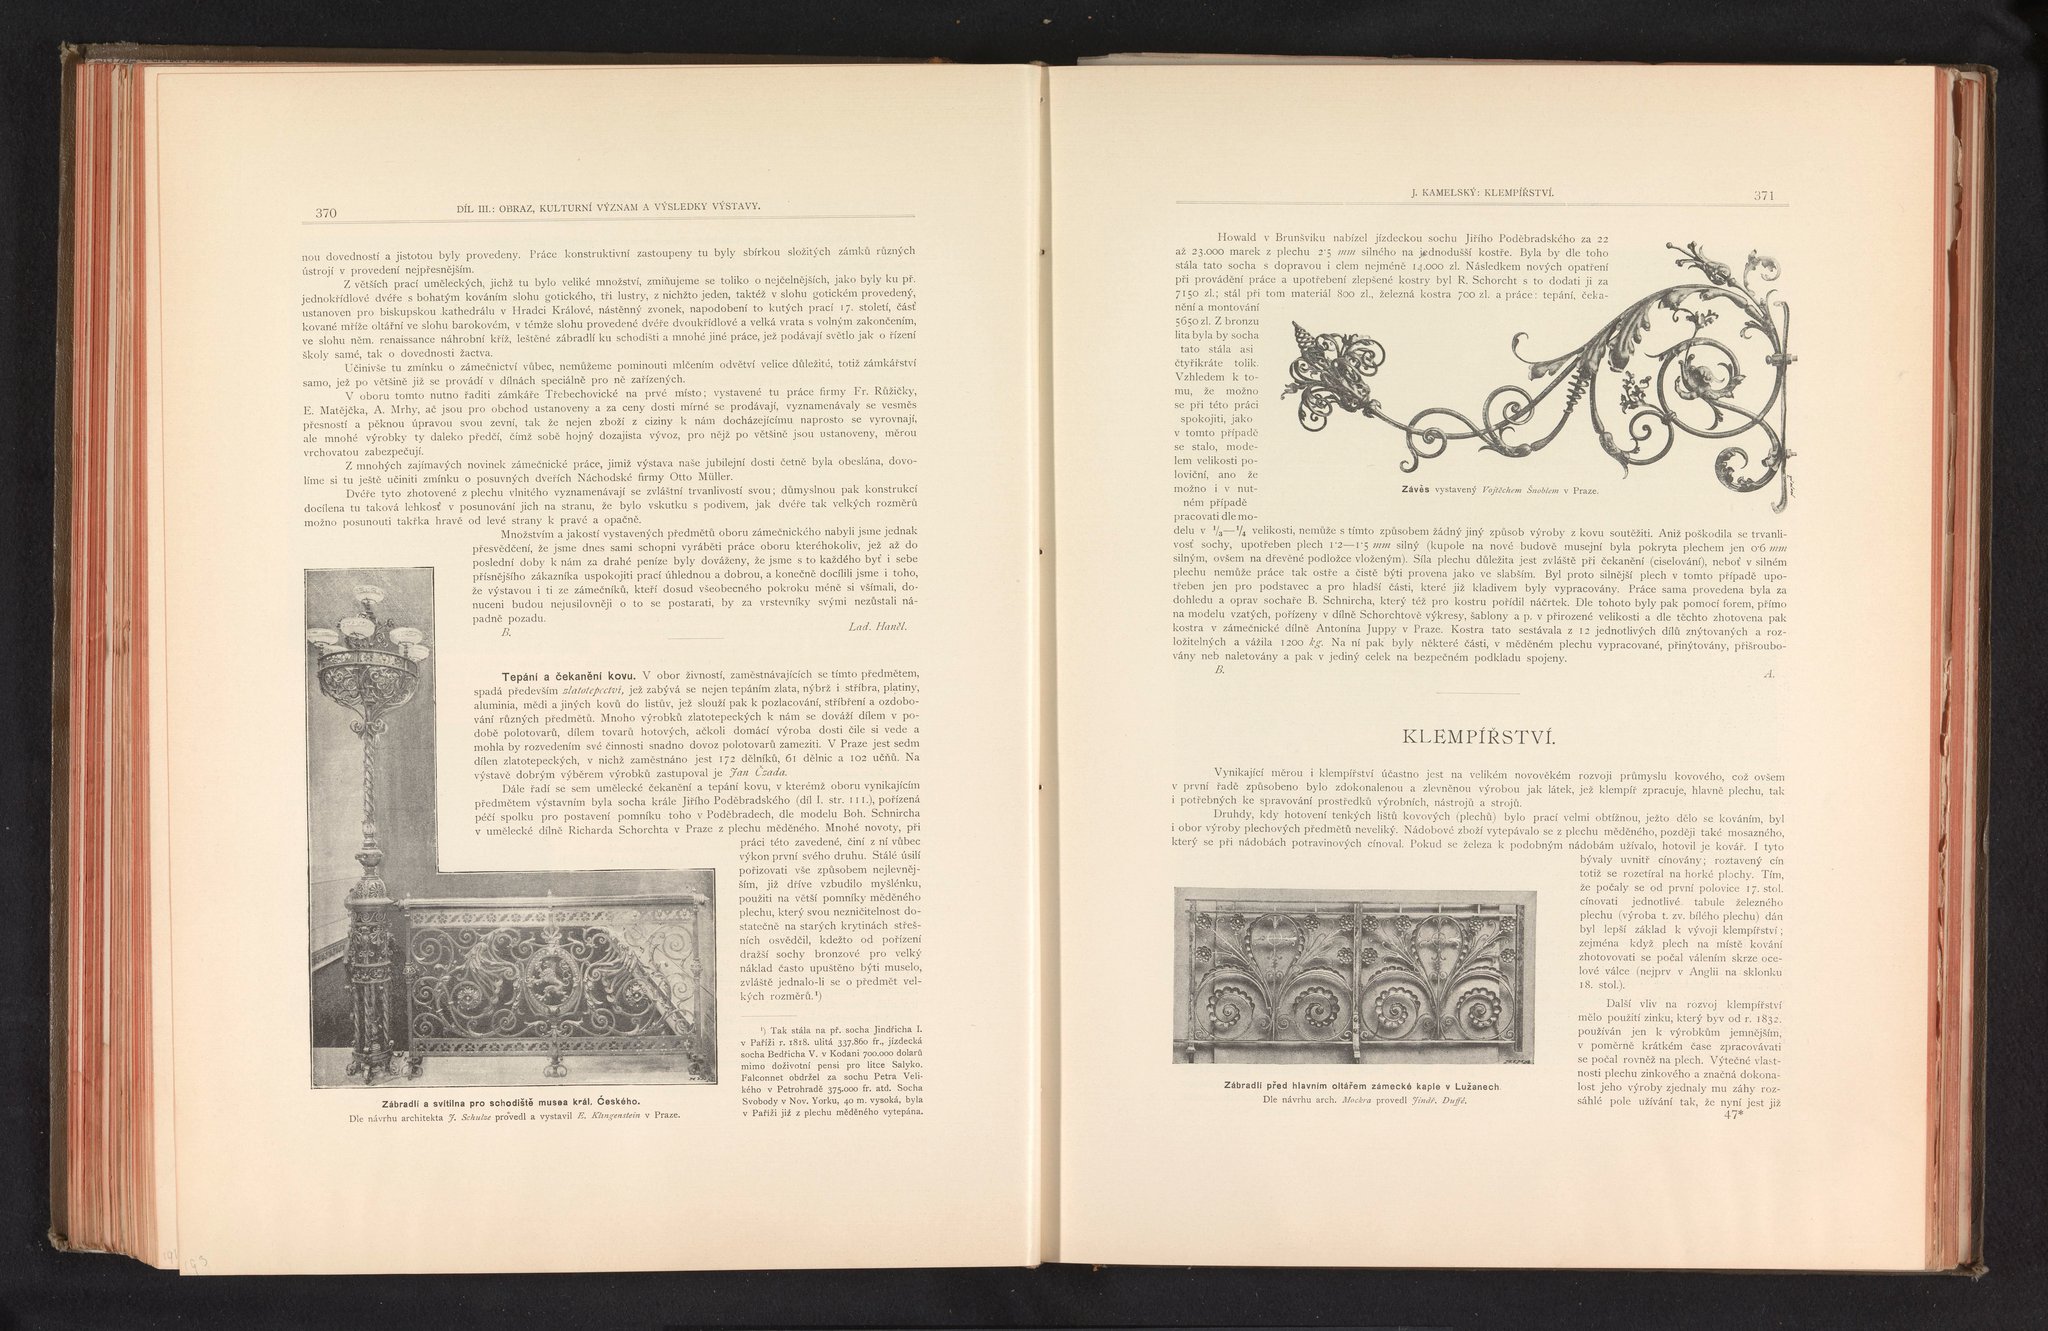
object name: photomechanical print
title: Zábradli a svitlina pro schodiste musea král. Ceského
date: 1890-1895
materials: paper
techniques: autotype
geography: prague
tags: staircase, lantern